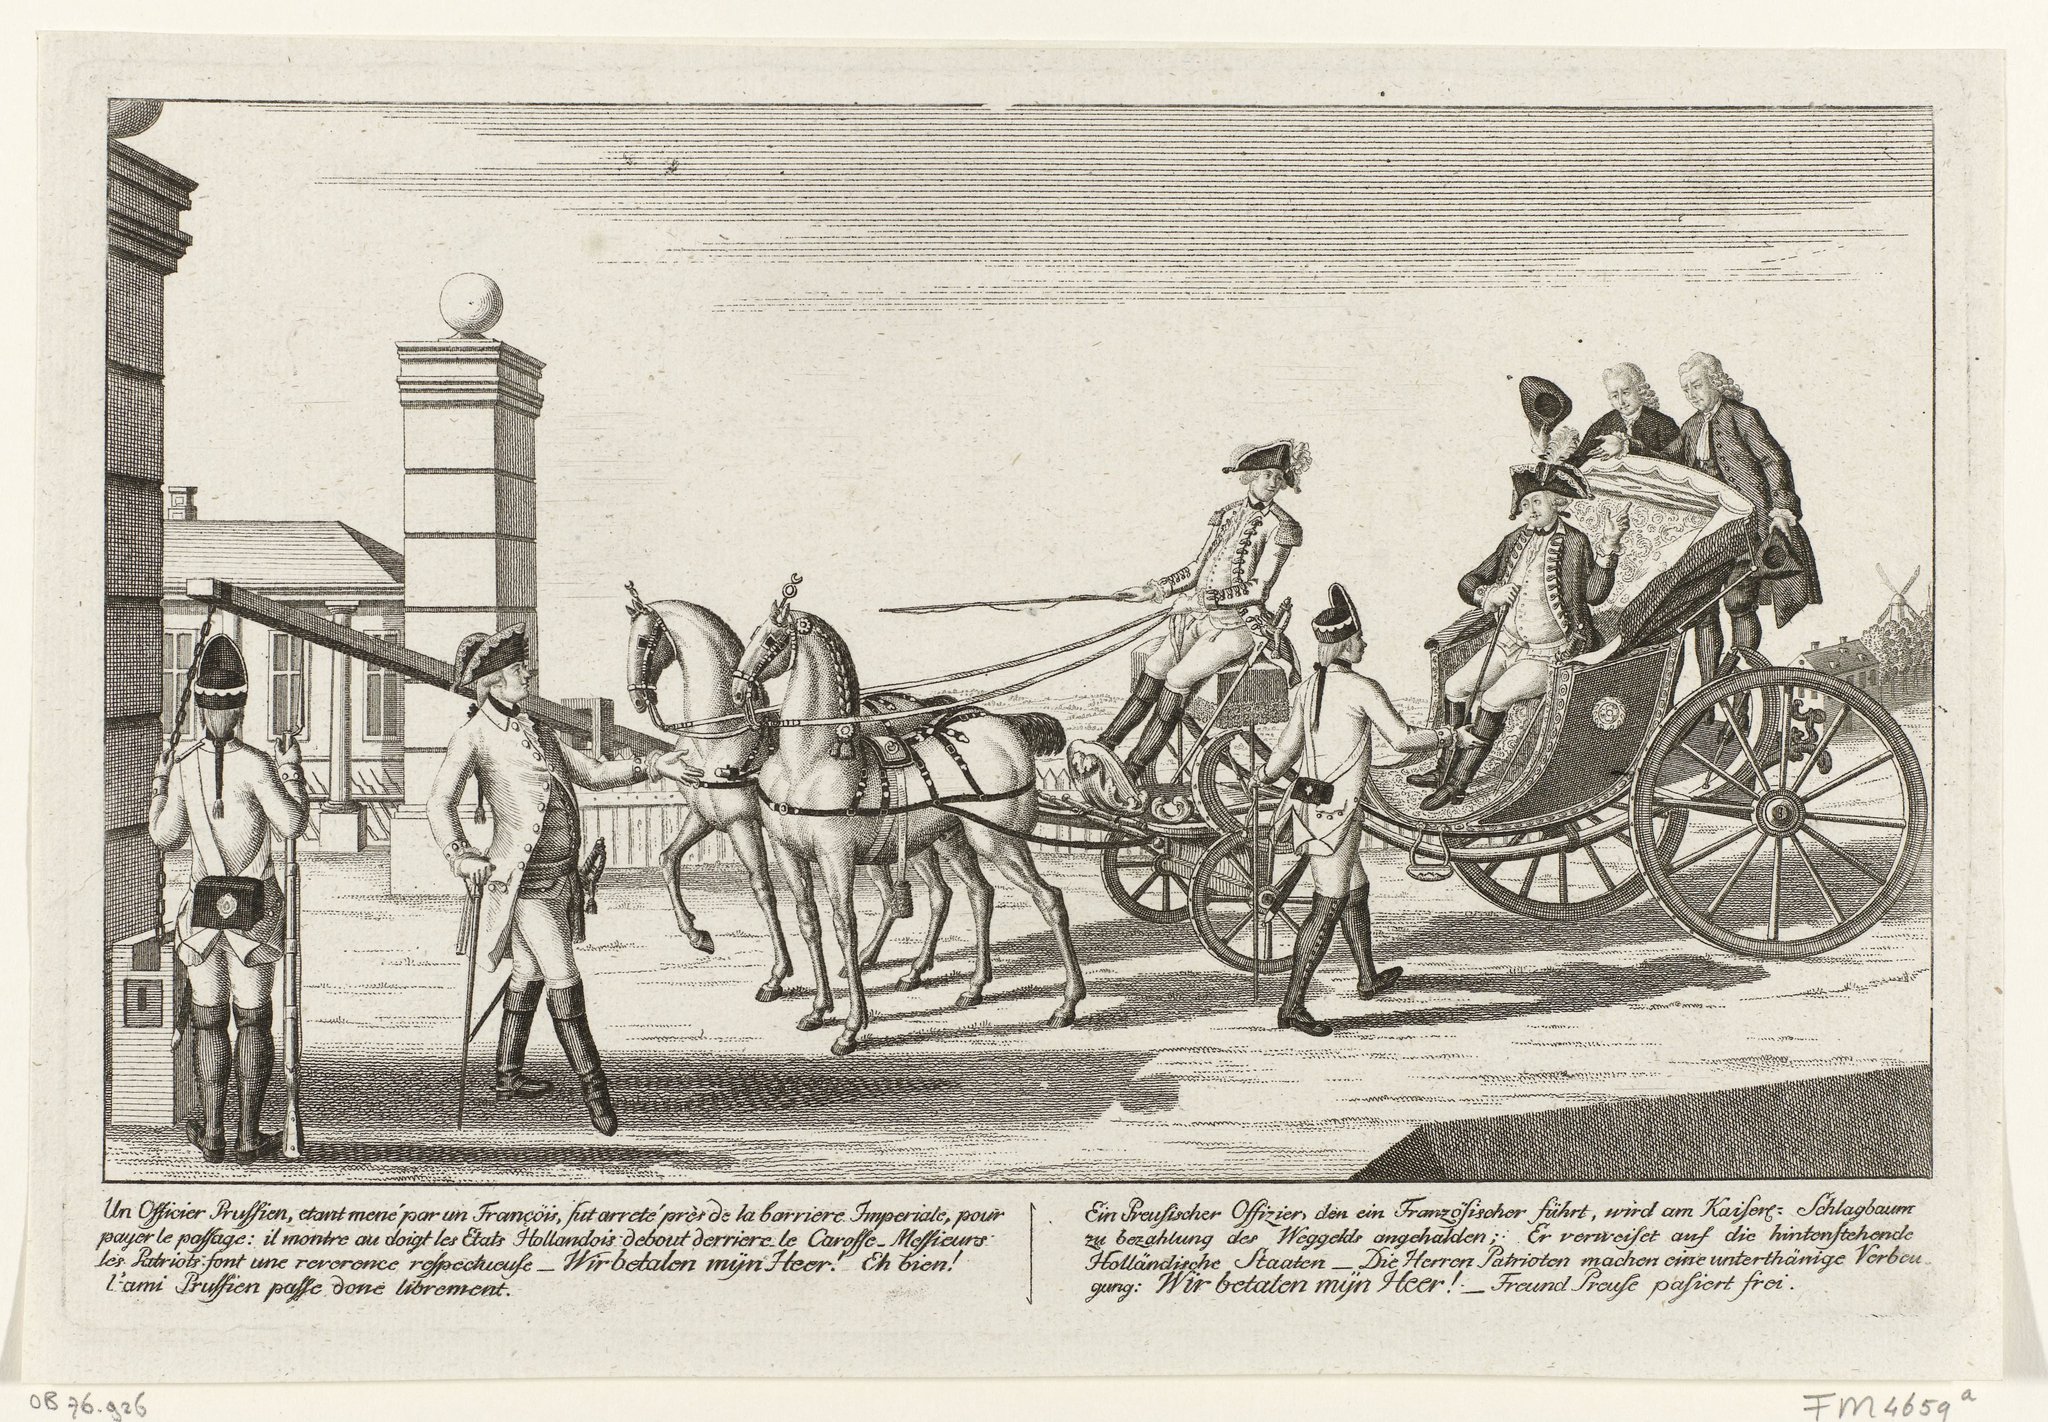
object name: print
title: Spotprent op de vrede tussen Nederland en de keizer, 1785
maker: Anonymous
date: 1785-1786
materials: paper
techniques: engraving, etching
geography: germany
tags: toll gate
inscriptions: collector's mark: Lugt 2228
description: Spotprent op het verdrag van Fontainebleau waarmee een eind kwam aan de Keteloorlog, de twisten tussen Nederland en de Oostenrijkse keizer Jozef II, 8 november 1785. Nederland betaalde 8,5 miljoen gulden en accepteerde andere vernederende voorwaarden. Links een Oostenrijkse tolboom waarbij een open koets, door een Frans officier gemend, waarin een Pruisissch officier zit; de officier wordt om betaling van barrièregeld aangehouden door de Oostenrijkse beambte, maar de twee Nederlandse lakeien (leden van de Hollandse Staten), die achter op het rijtuig staan, zeggen: 'Wij betalen mijn Heer!' waarop de Pruis zijn tocht kan vervolgen. In het onderschrift een verklaring in het Frans en Duits.